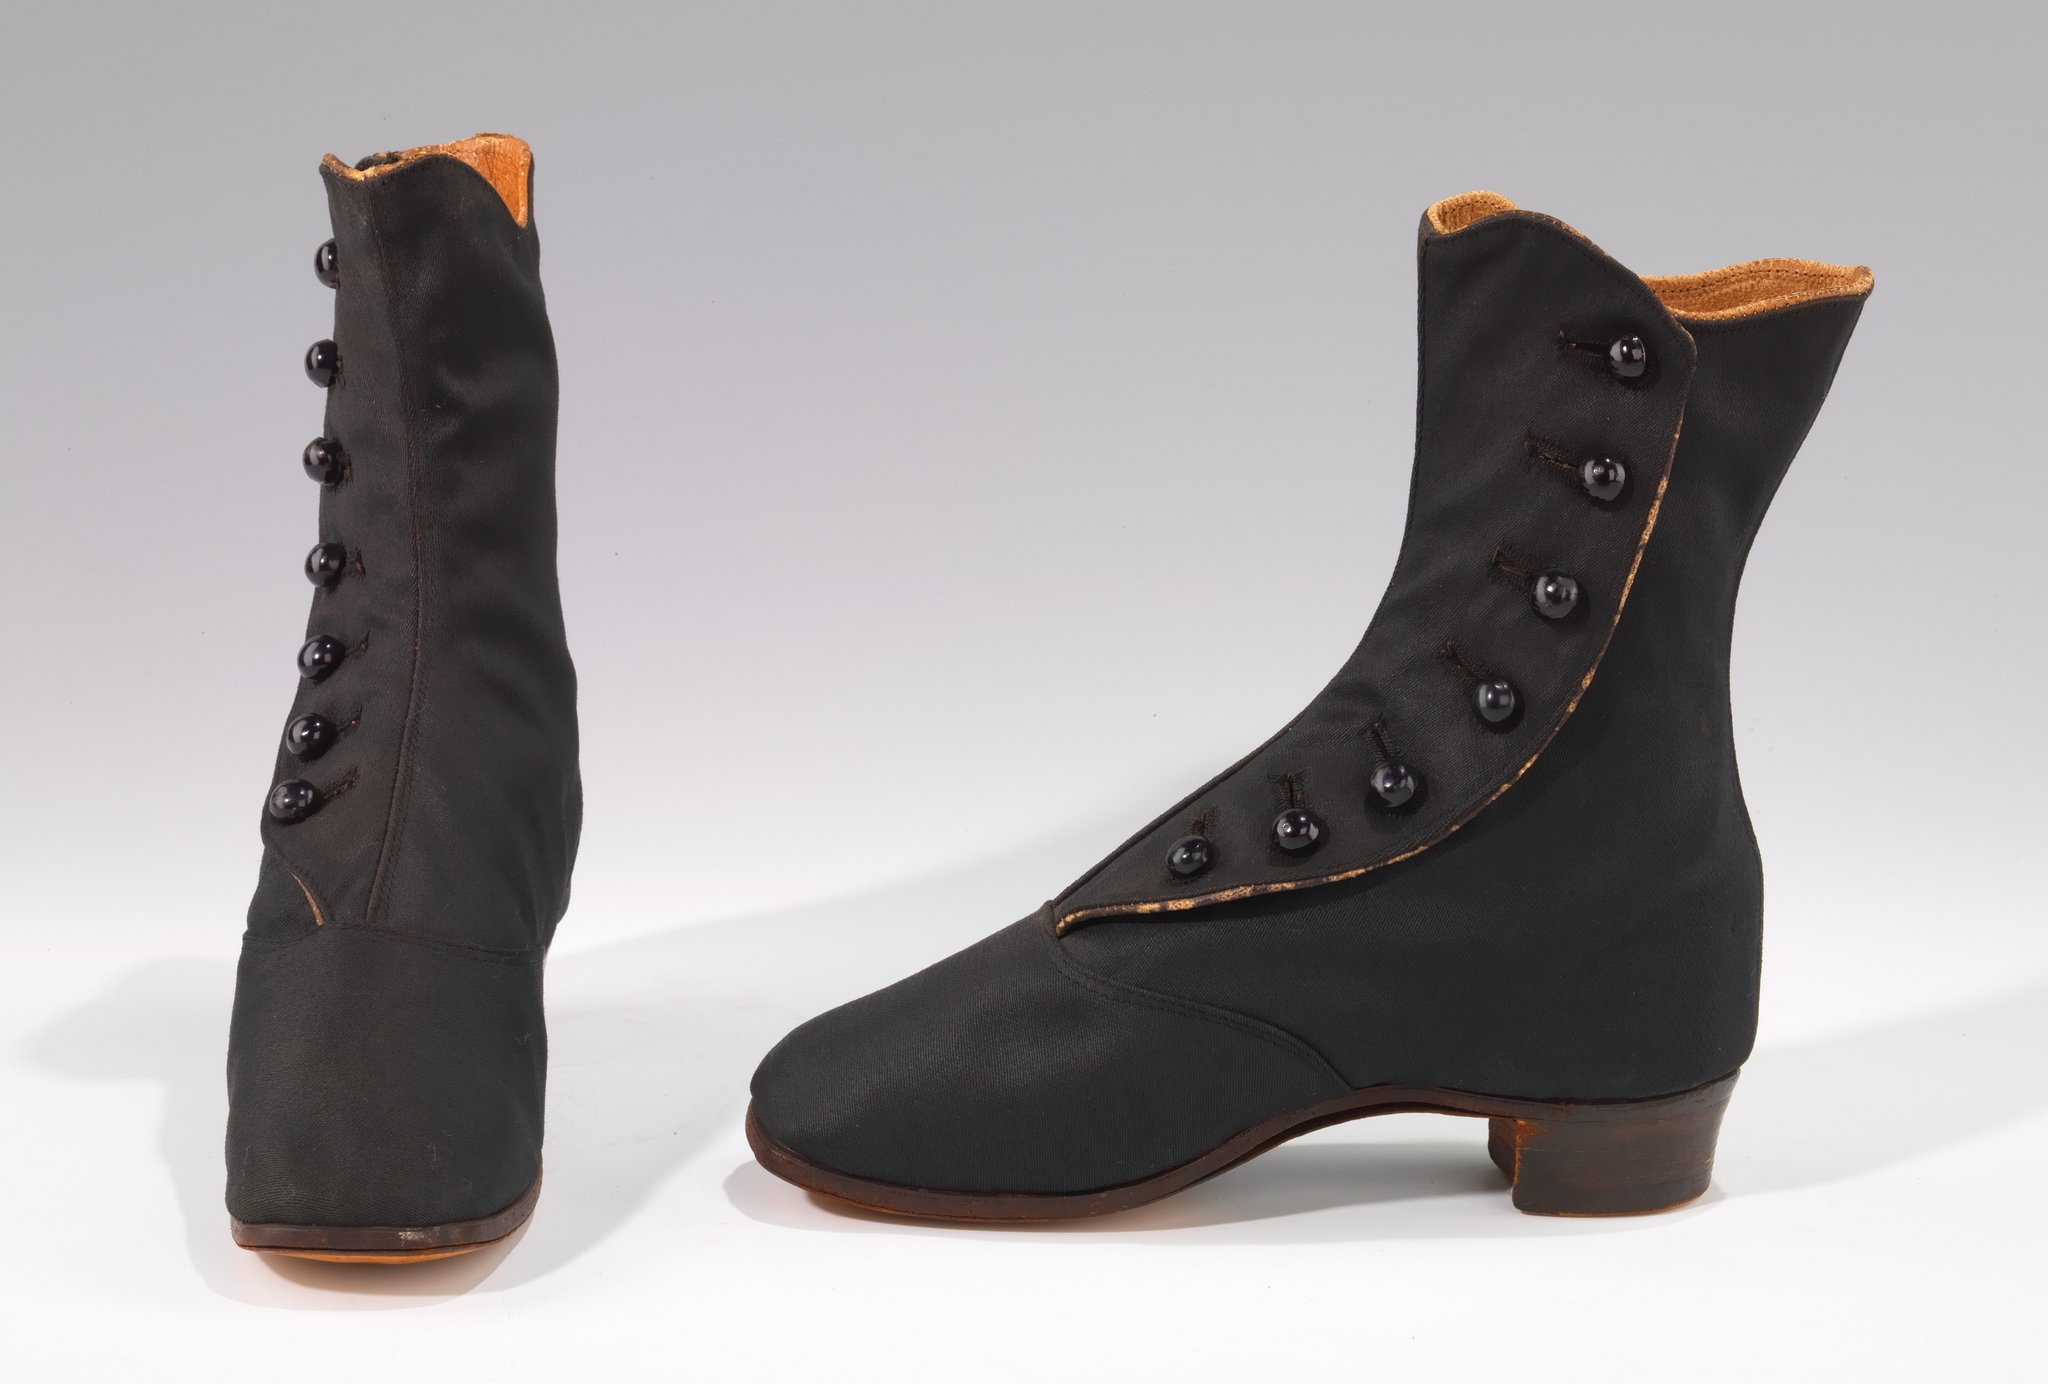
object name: boot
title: Boots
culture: american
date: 1865-1875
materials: wool